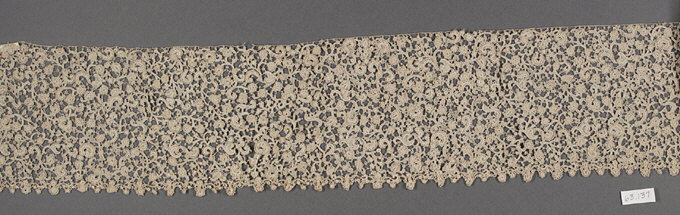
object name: border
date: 1801-1900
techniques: lace